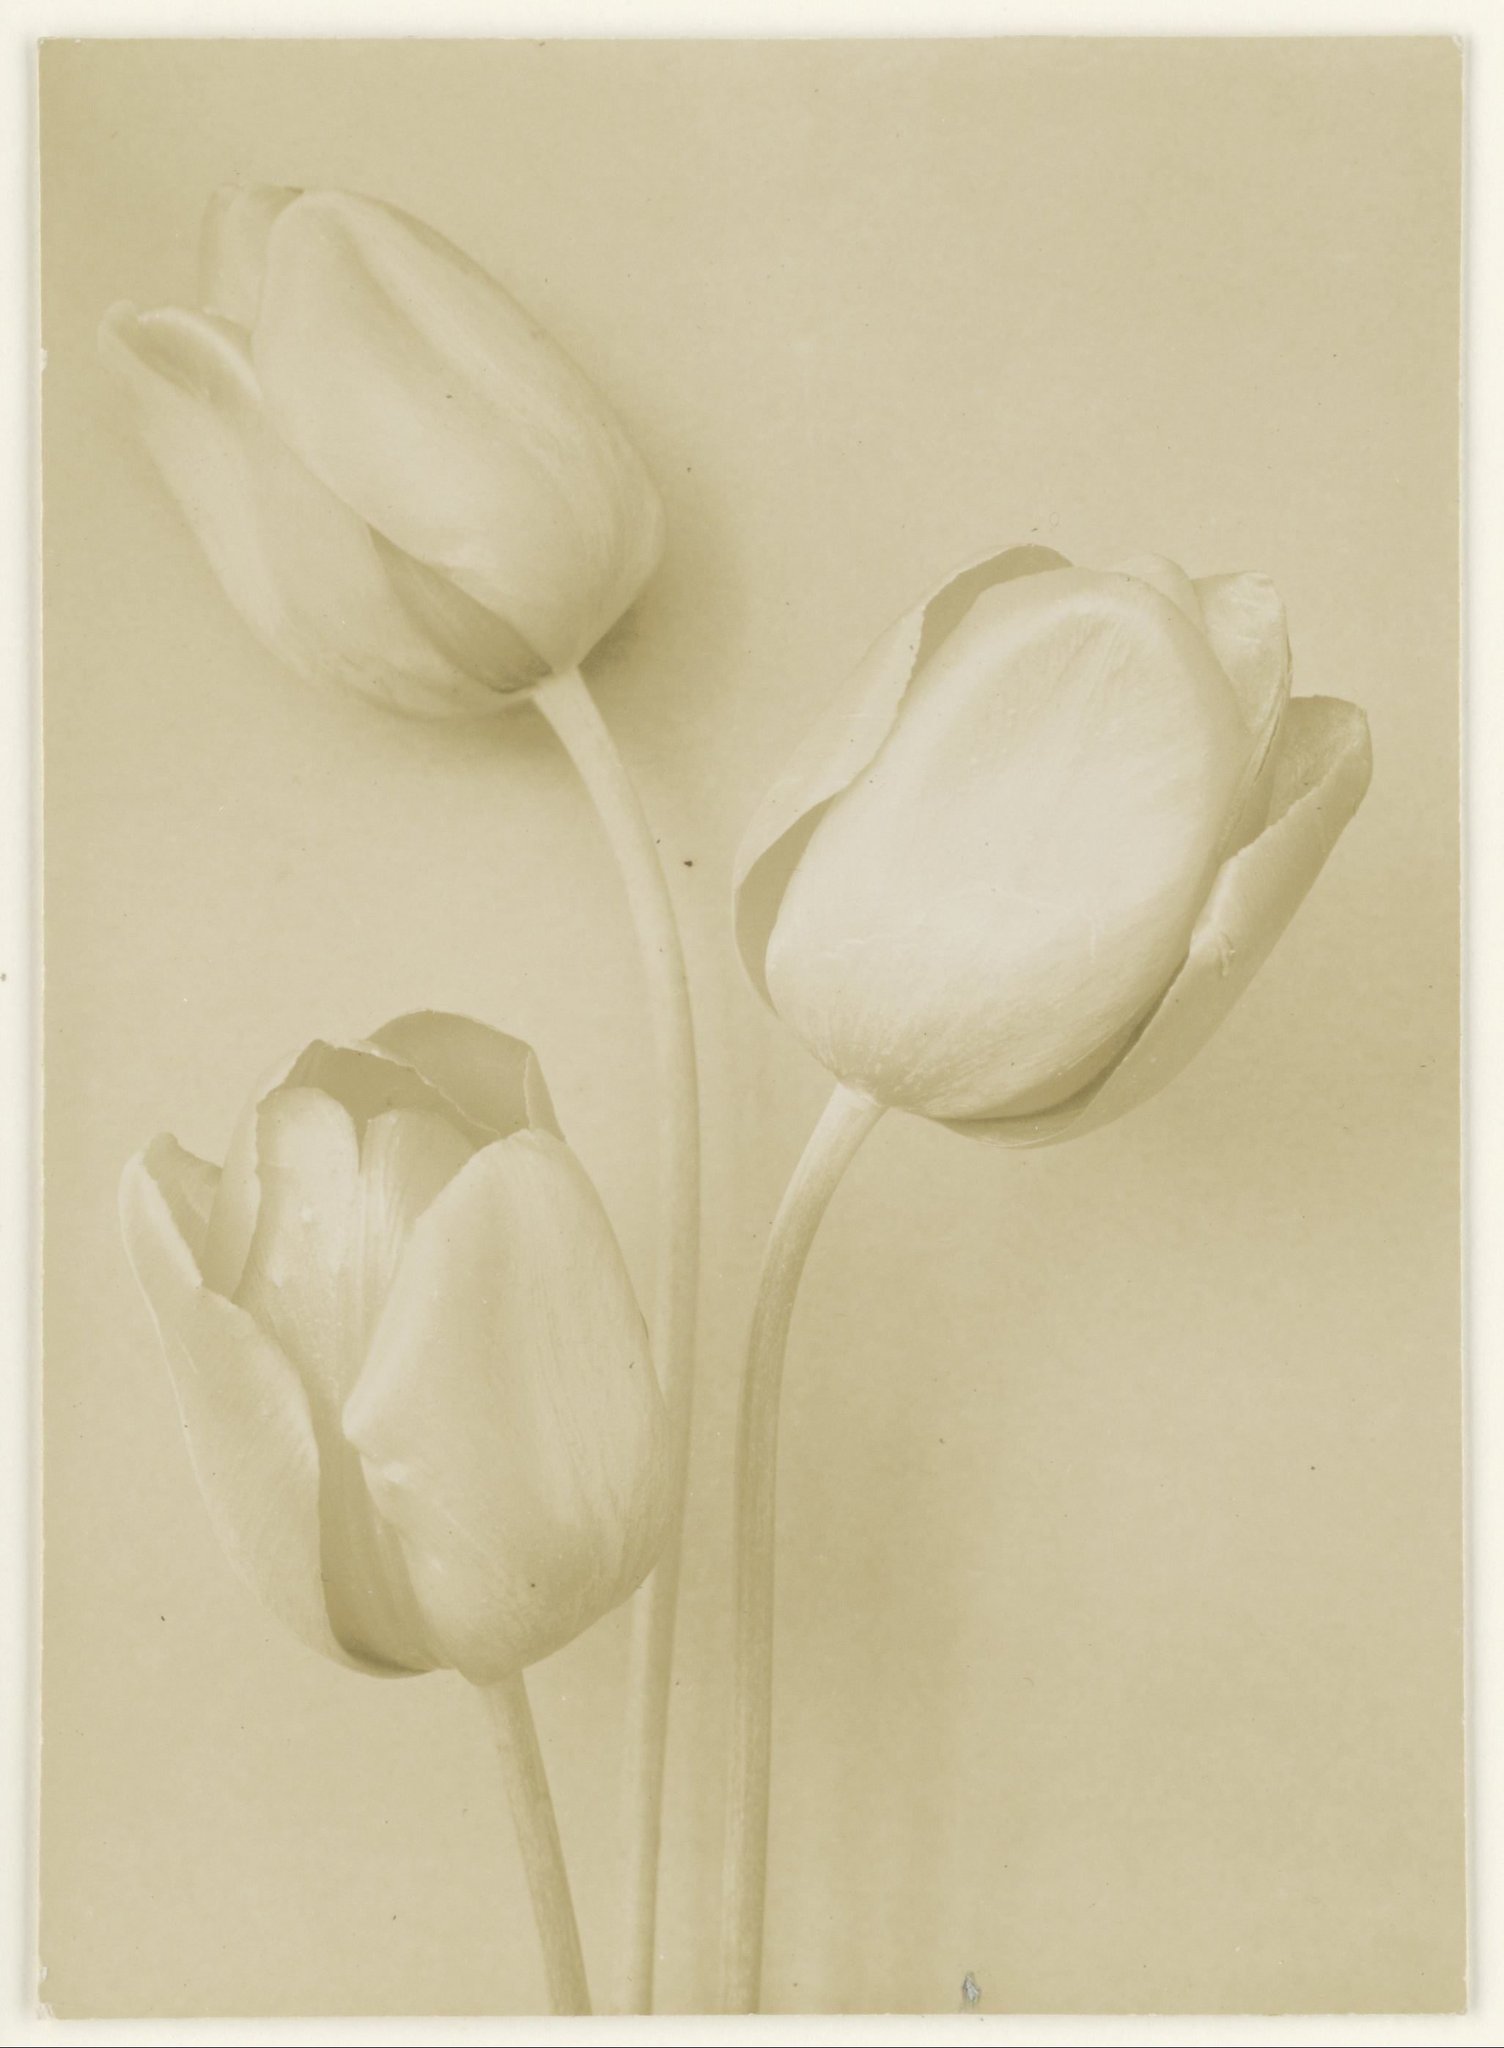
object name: photograph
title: Drie tulpen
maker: richard tepe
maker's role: fotograaf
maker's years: 1864-1952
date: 1900-1930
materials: paper, photographic support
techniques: gelatin silver print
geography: netherlands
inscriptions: annotation: ‘Late Tulp "Bouton d'Or"’, signature: ‘foto R.Tepe’